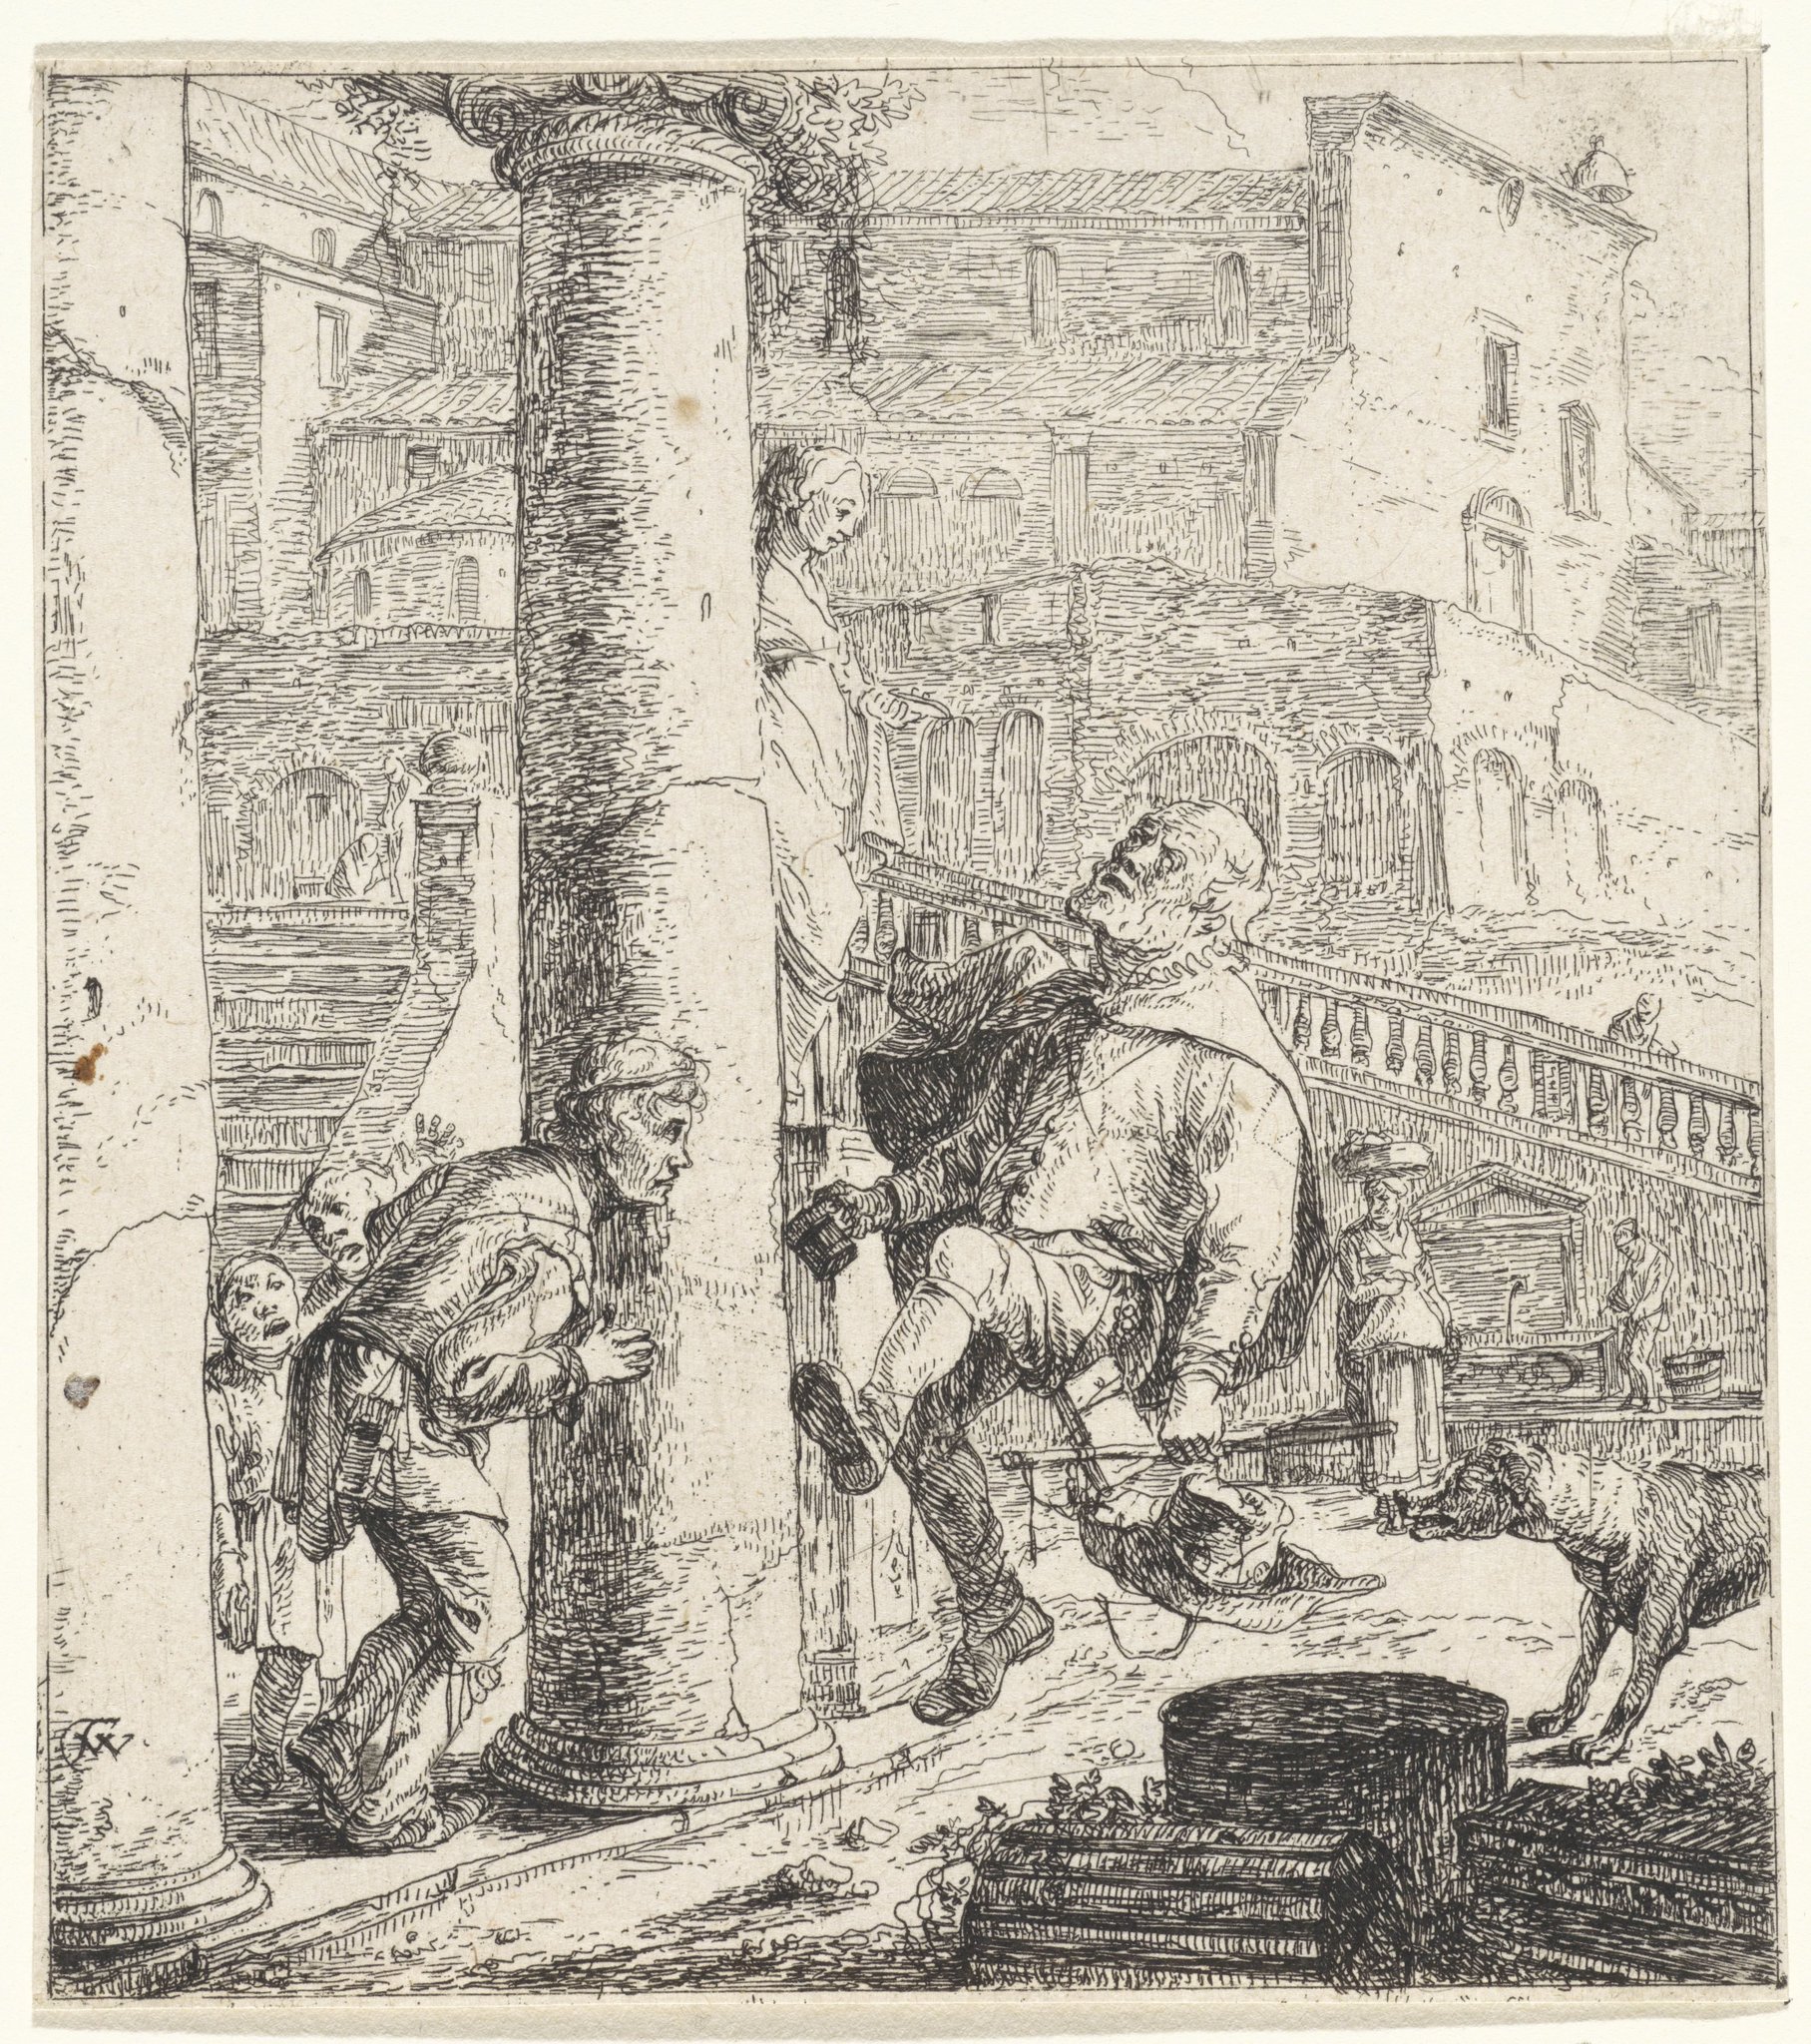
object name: print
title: Man loopt tegen zuil op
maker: thomas wijck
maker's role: draughtsman, painter, print maker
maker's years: 1616-1677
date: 1626-1677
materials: paper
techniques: etching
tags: male literary characters (with name), column, pillar ~ architecture, church (exterior)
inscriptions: collector's mark: Lugt 240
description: Scène uit de anonieme Spaanse schelmenroman Lazarillo van Tormes. De jonge Lázaro is de vernederingen van zijn meester zat waarop hij hem opzettelijk tegen een zuil laat aanlopen. Op de achtergrond een kerk (Santa Maria in Coeli te Rome?).